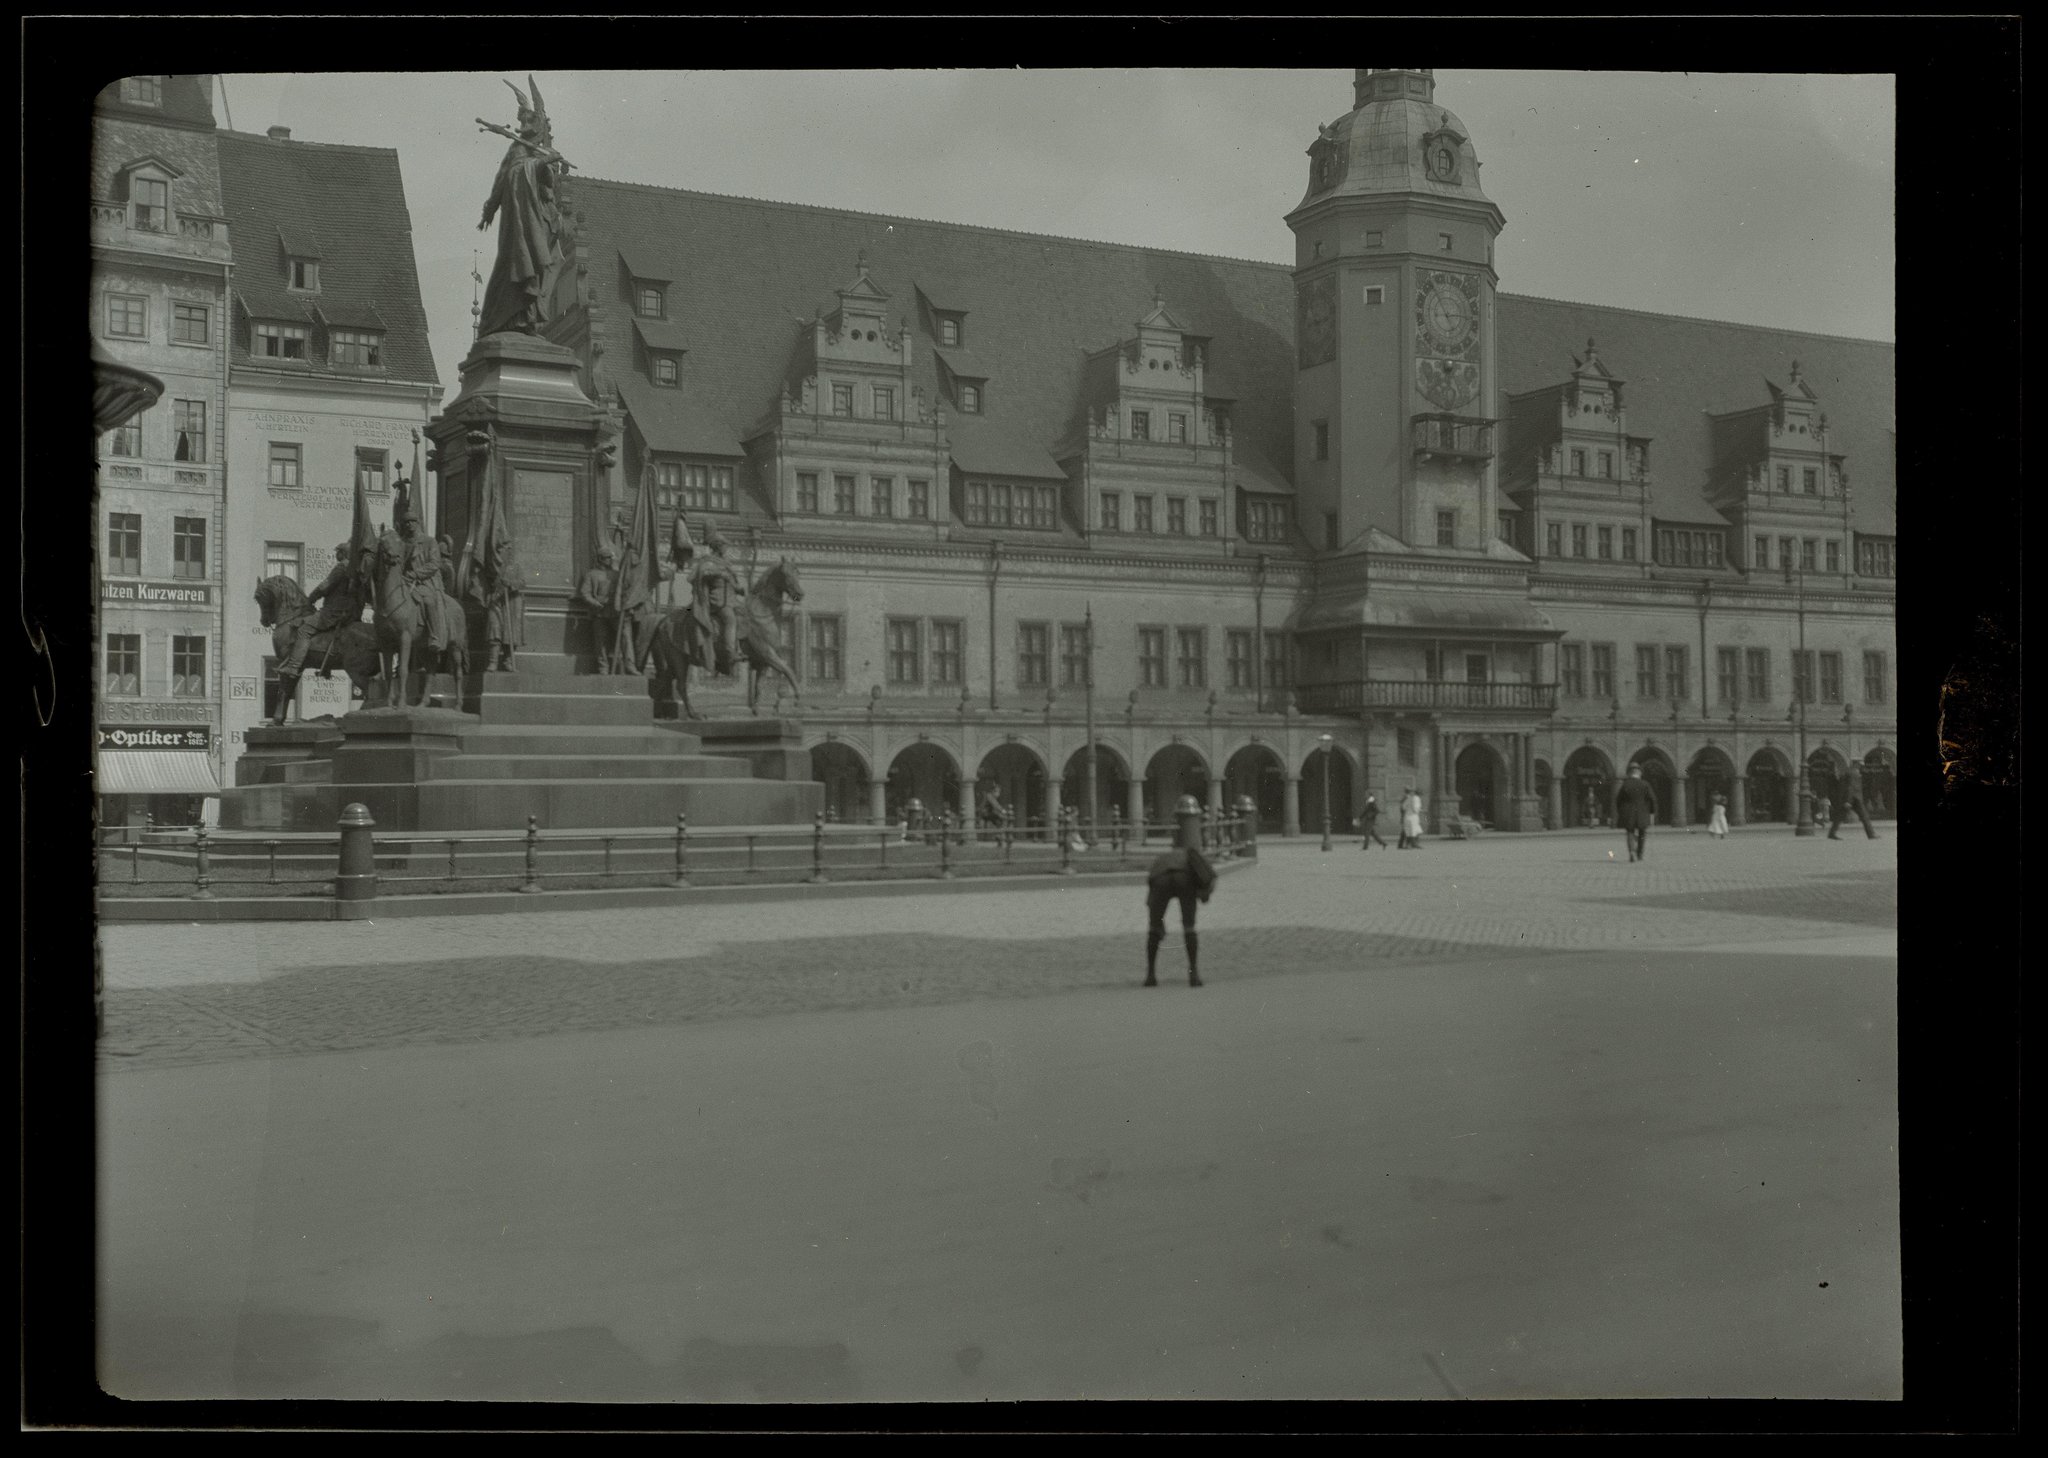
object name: negative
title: Filmnegatief met opname van Leipzig en huis te Bünde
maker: Anonymous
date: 1921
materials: film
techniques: gelatin silver negative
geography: germany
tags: germany